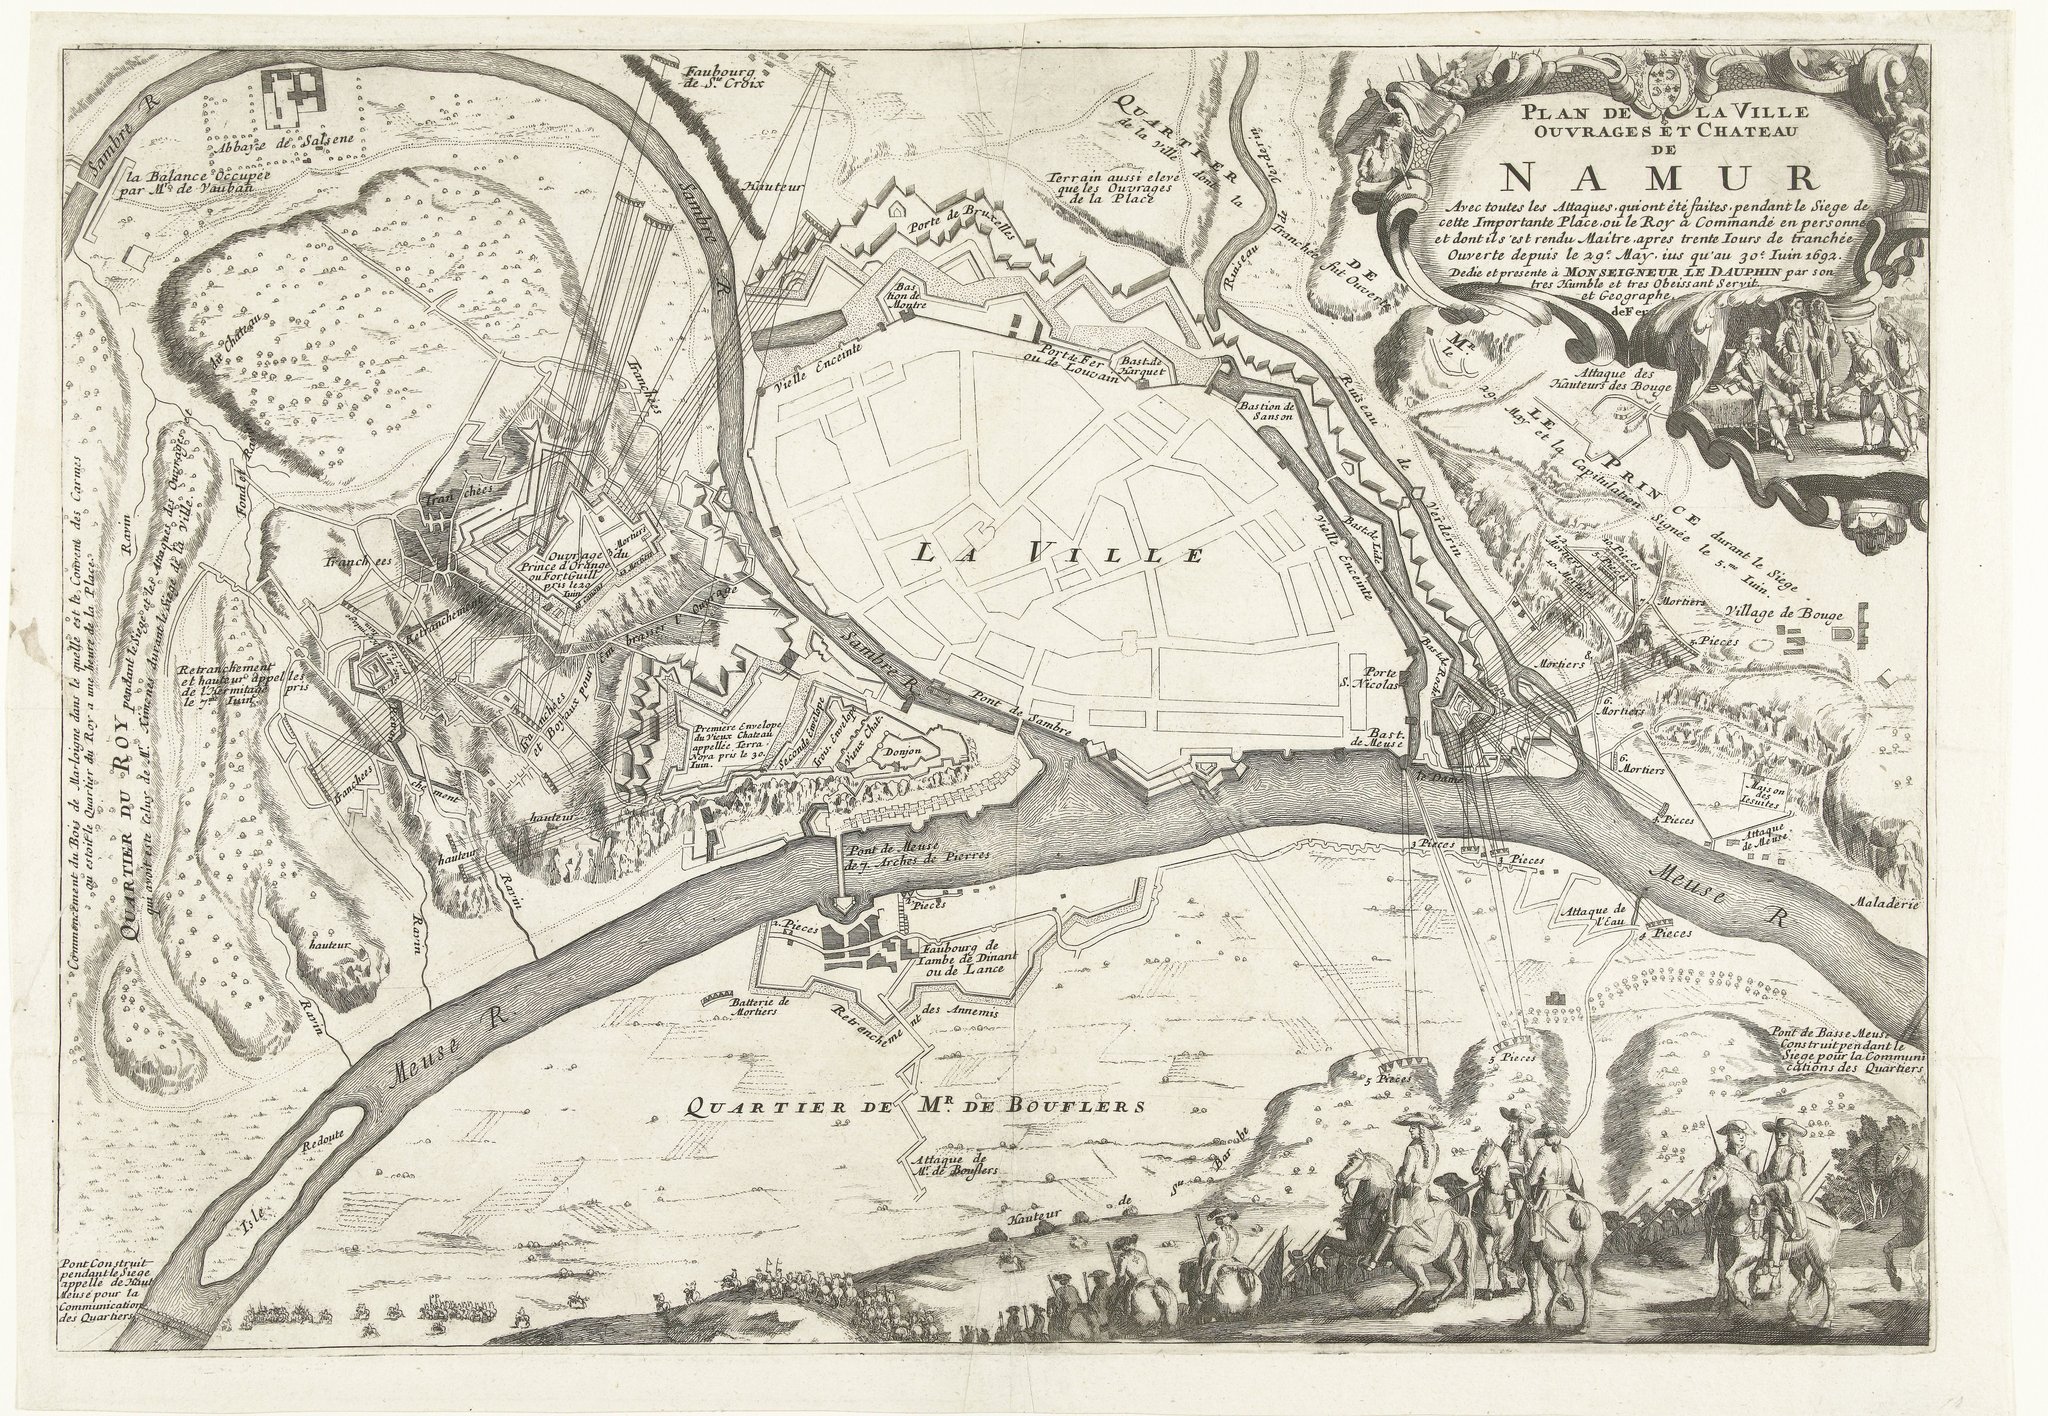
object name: print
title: Plan de la Ville ouvrages et Chateau de Namur Avec toutes les Attaques, qui ont été faites, pendant le Siege (...) depuis le 29e May jus qu au 30e Juin 1692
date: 1692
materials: paper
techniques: engraving, etching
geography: france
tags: siege, position war, maps of cities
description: Kaart van de stad Namen met het kasteel, belegerd door het Franse leger, 25 mei - 30 juni 1692. Bovenaan onder de cartouche het aanbieden van de overgave van de stad aan de Franse bevelhebber. Onderaan oprukkende ruiterij.